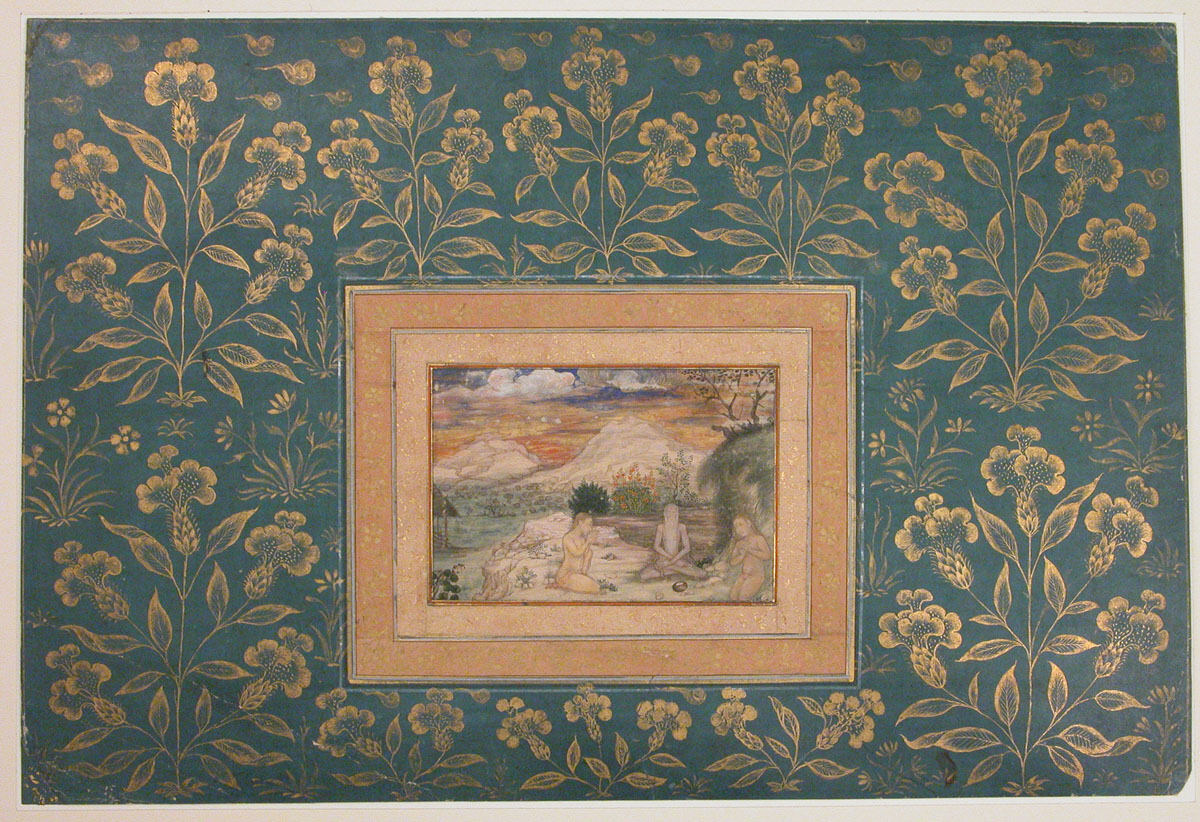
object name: illustrated single work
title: Holy Man with Two Disciples in a Landscape Setting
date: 1640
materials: gold, ink, paper, watercolor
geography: india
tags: men,female nudes,hills,landscapes,trees